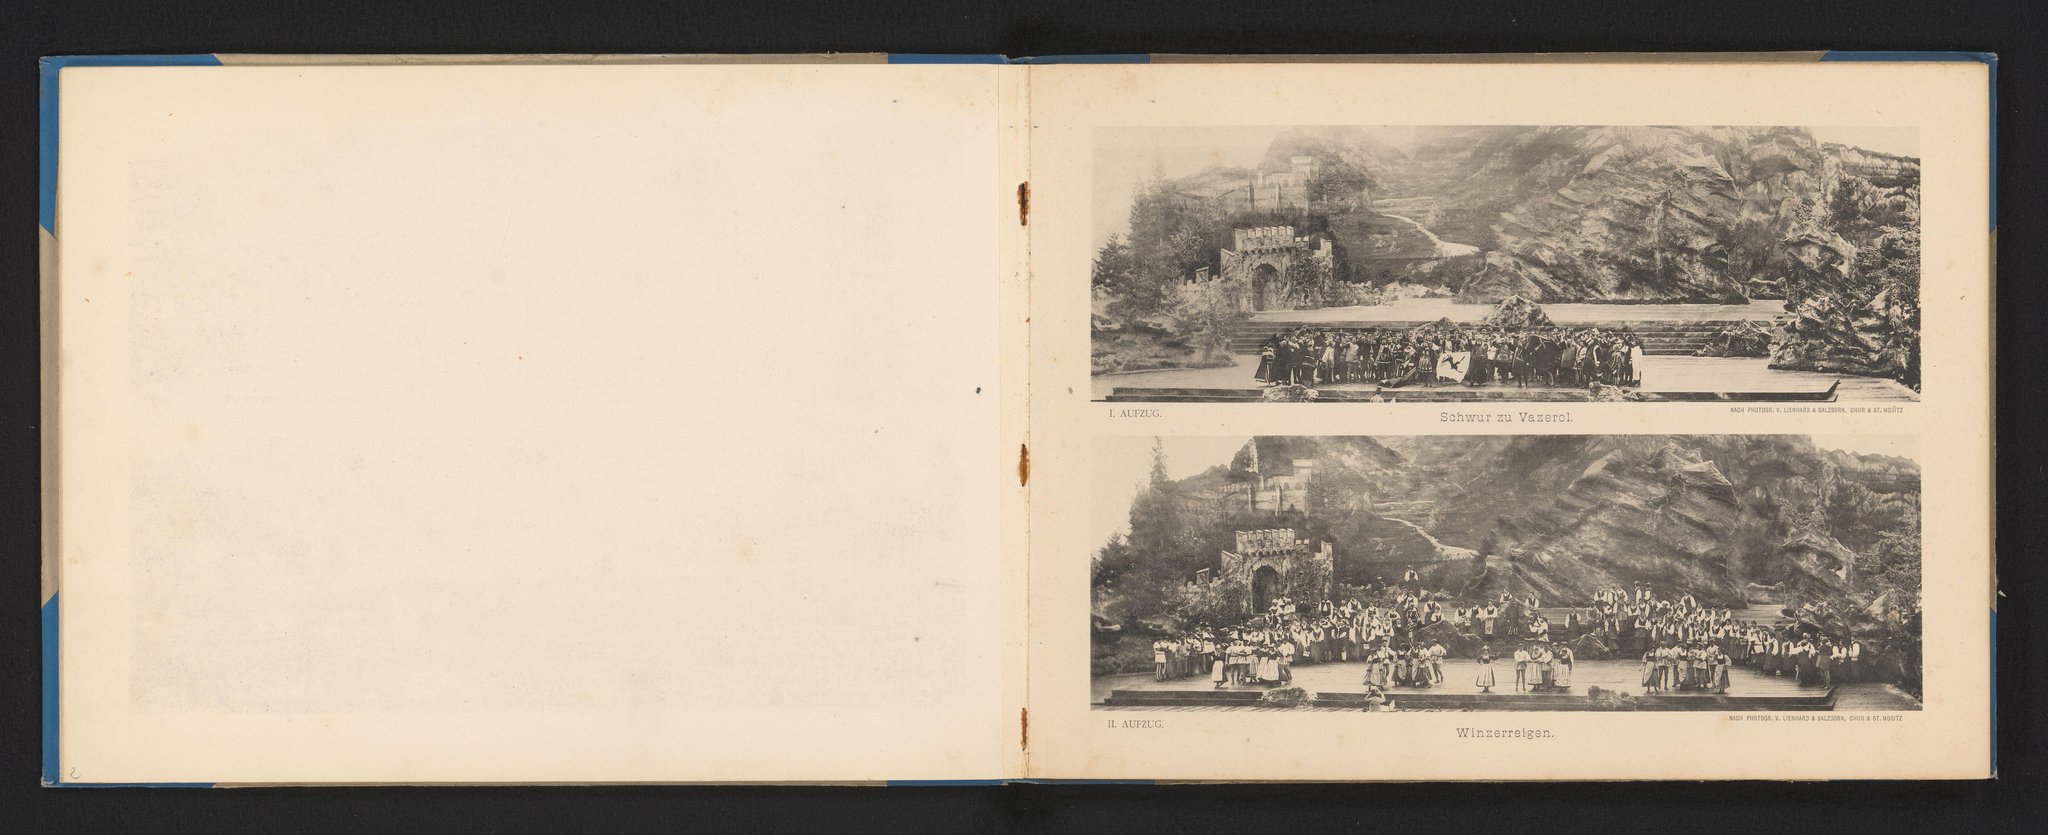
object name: photomechanical print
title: Gezicht op een eed aan Vazerol en een opvoering tijdens de Calven-Feier te Chur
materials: paper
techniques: photograph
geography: chur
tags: activities in the air ~ public festivities, e.g. fly-past, musical drama, performance of musical drama, swearing an oath (with two fingers raised)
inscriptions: number: ‘I. II.’